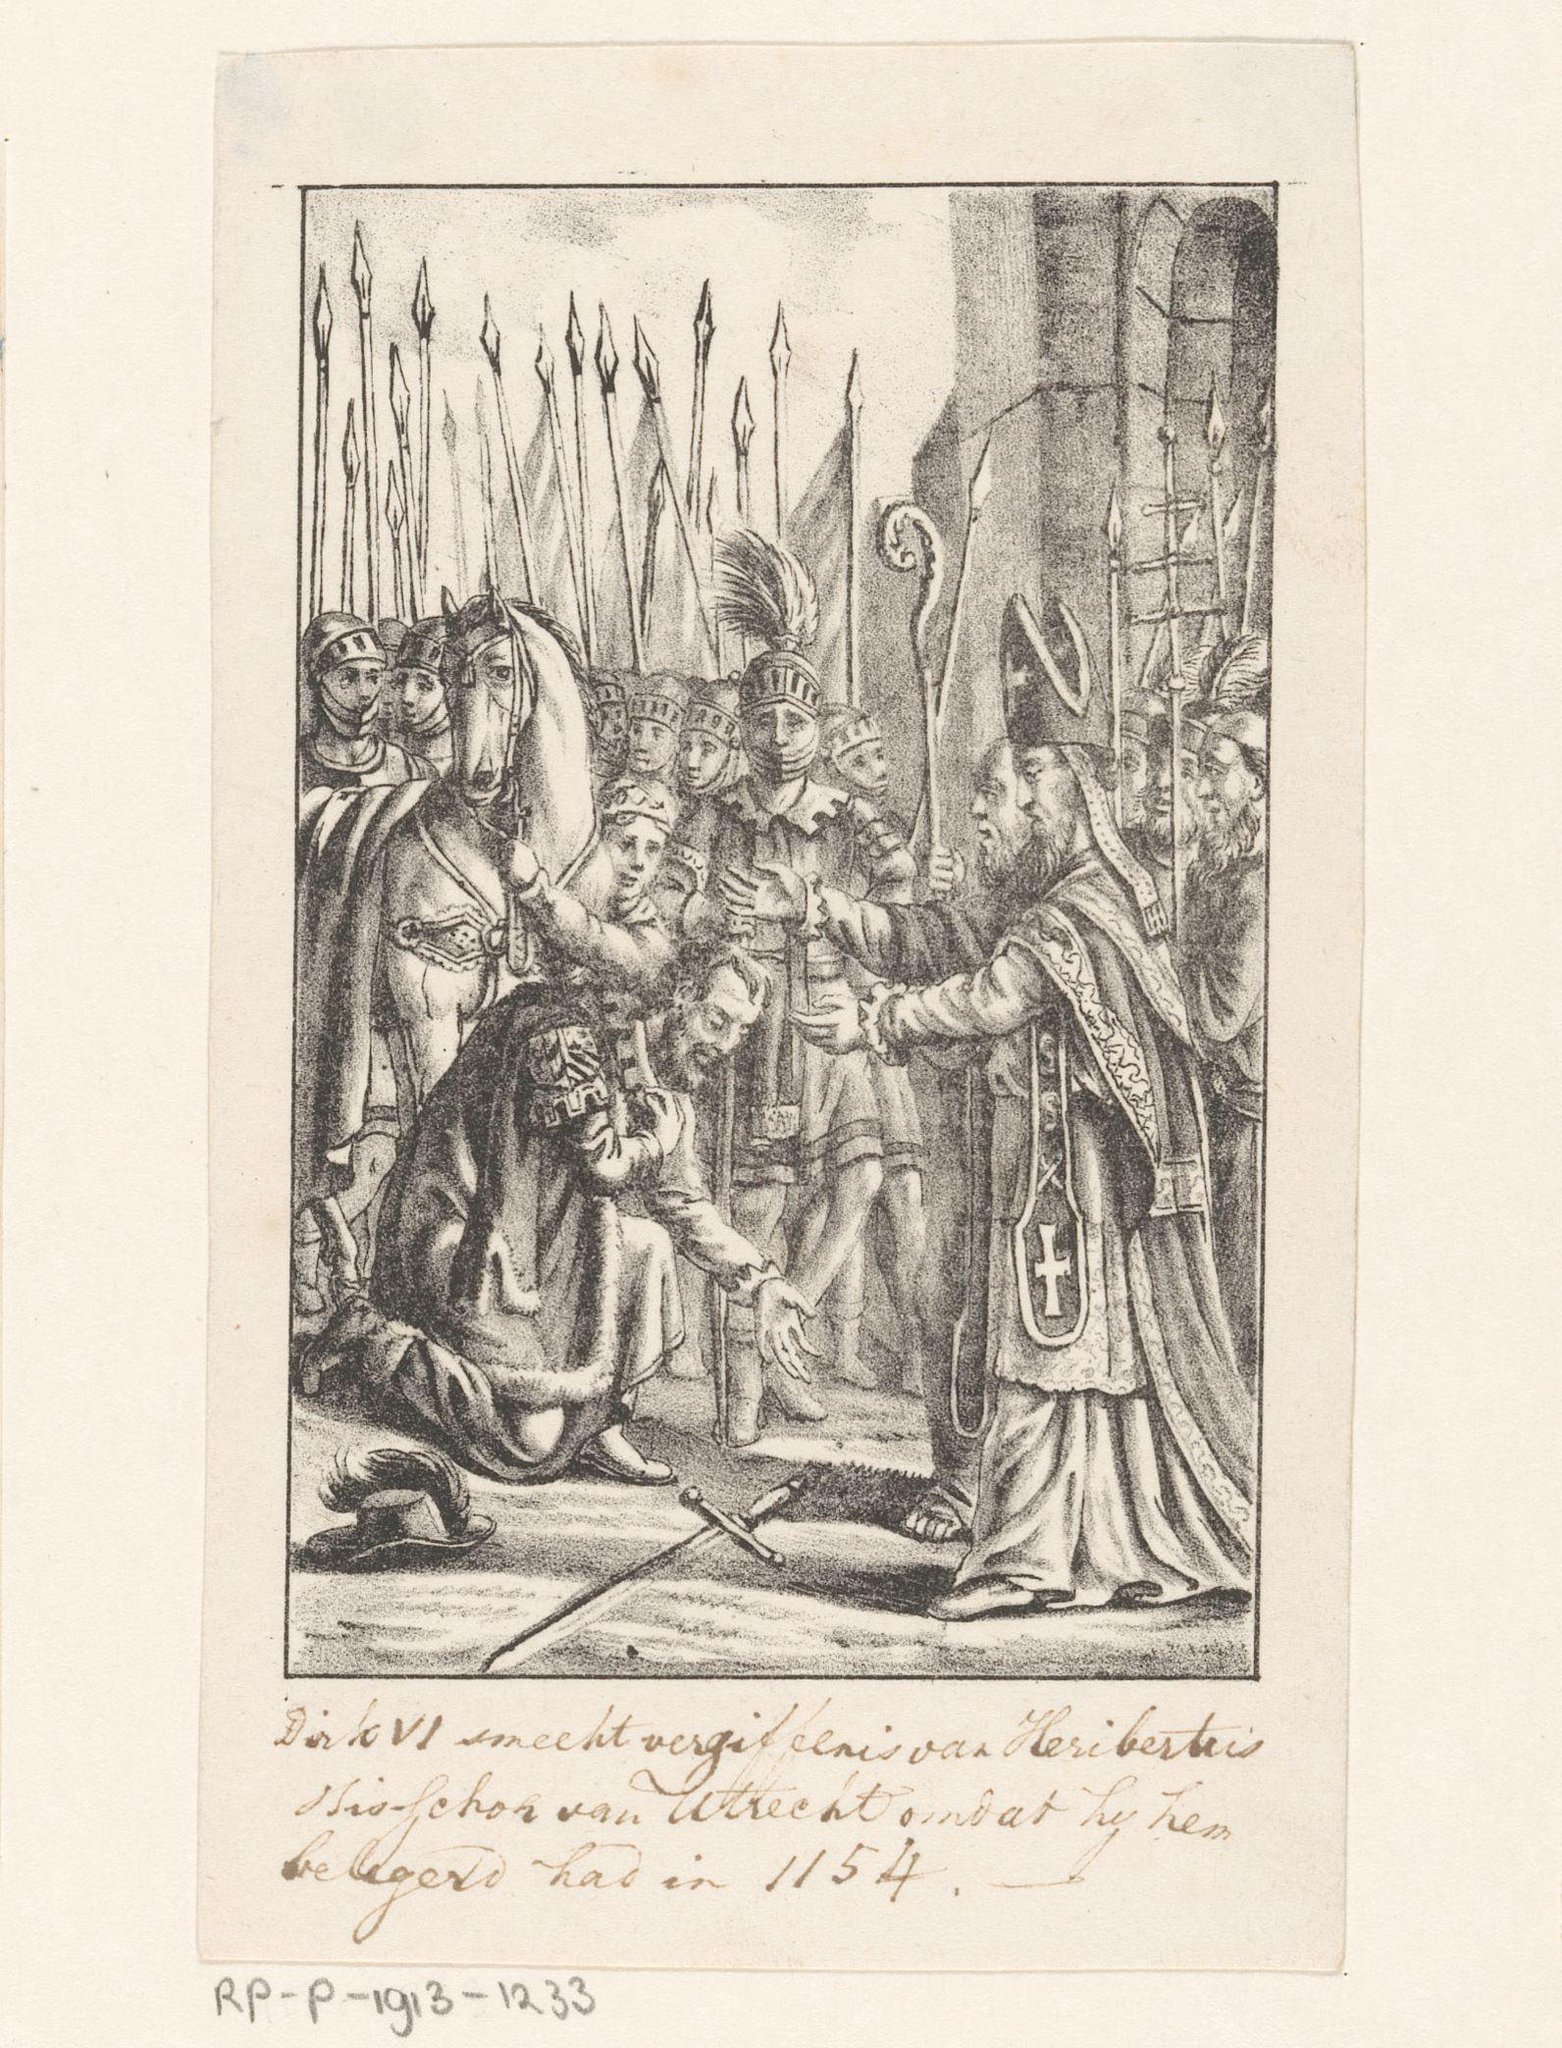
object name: print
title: Serie prenten over historische gebeurtenissen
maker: Anonymous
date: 1809-1899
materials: paper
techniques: lithograph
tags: forgivingness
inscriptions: collector's mark: Lugt 2228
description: Dirk VI, graaf van Holland, smeekt Hartbert van Bierum, bisschop van Utrecht om vergiffenis. Dirk belegerde de stad Utrecht in 1146. Toen de bisschop dreigde de graaf in de ban te doen, kwam Dirk tot inkeer.